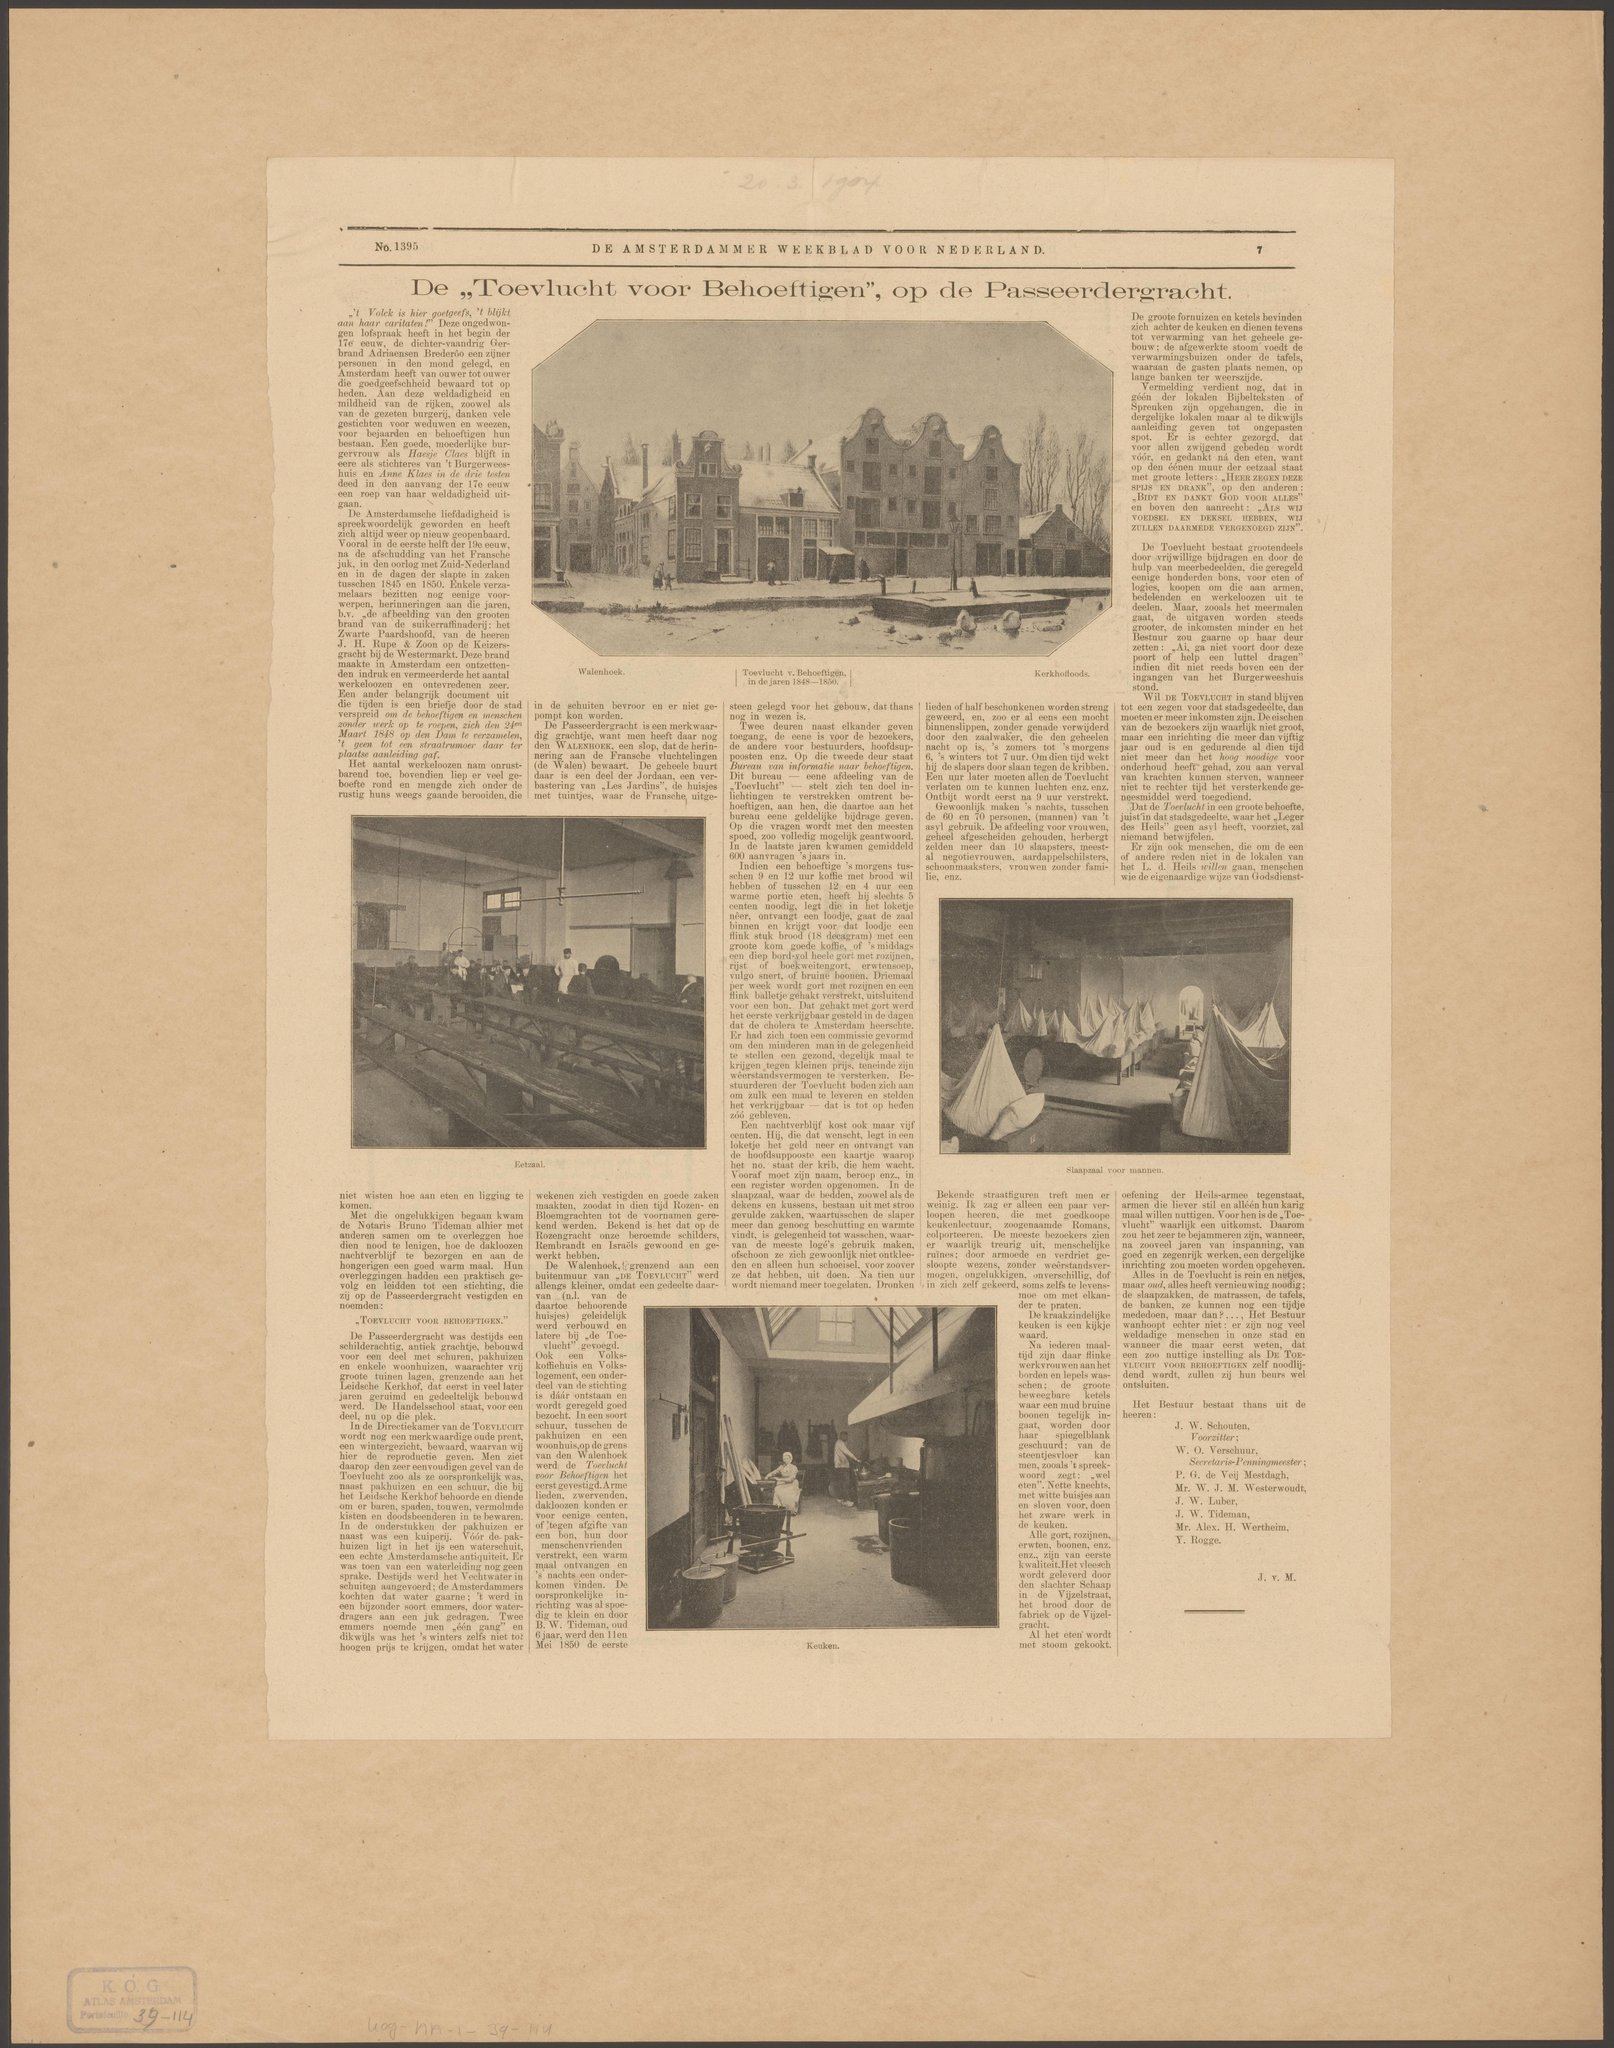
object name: photomechanical print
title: Artikel over het tehuis Toevlucht voor Behoeftigen te Amsterdam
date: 1904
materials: paper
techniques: letterpress printing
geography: netherlands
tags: kitchen, public welfare, communal rooms, bed, canals, waters (in city) (+ city(-scape) with figures, staffage)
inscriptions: collector's mark: Lugt 1641b, signature: ‘J.v.M.’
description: Onderwerpsrubriek binnen de Atlas Amsterdam: Armwezen en liefdadige instellingen: III. Verschillende gestichten en instellingen / Hofjes: Toevlucht voor Behoeftigen.